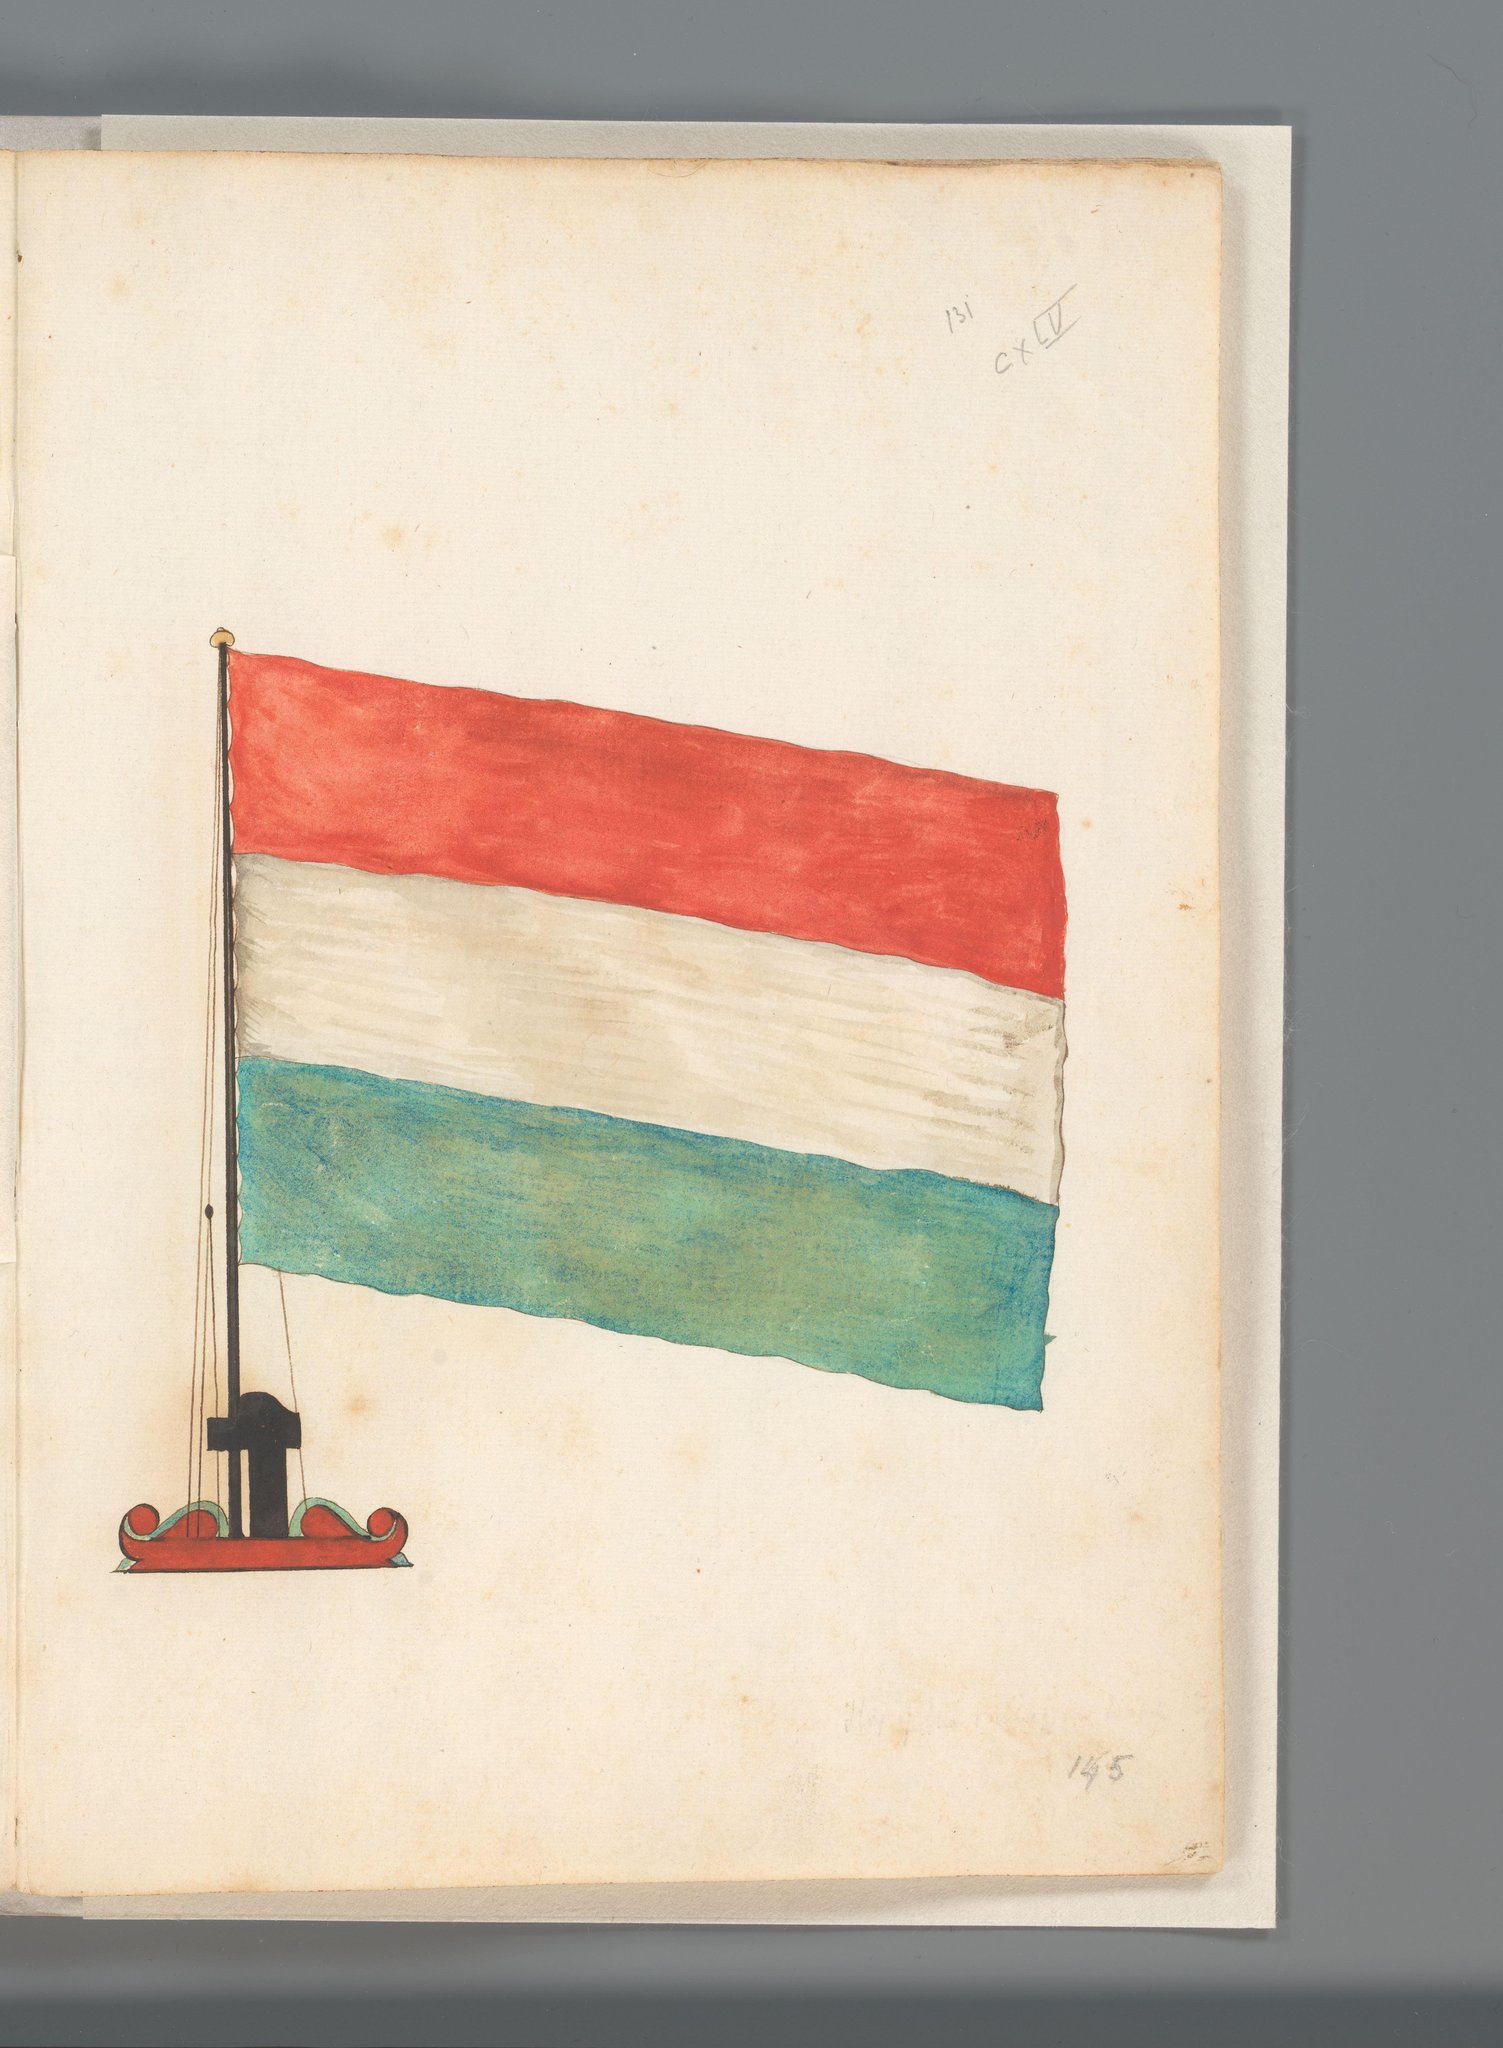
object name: drawing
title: Vlag van de Republiek der Zeven Verenigde Nederlanden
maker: Anonymous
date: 1667-1670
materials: ink, paper, watercolor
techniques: brush, pen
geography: france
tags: flag, colours (as symbol of the state, etc.), netherlands, dutch republic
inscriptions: number: ‘131 / CXLV / 145’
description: Vlag van de Republiek der Zeven Verenigde Nederlanden. Vlag met drie horizontale banen in rood, wit en blauw. Vlag op vlaggensteng en mastvoet. Afgebeeld op folio 73r. Onderdeel van een vlaggenboek met vlaggen uit Europa, Noord-Afrika, Nabije en Verre Oosten.